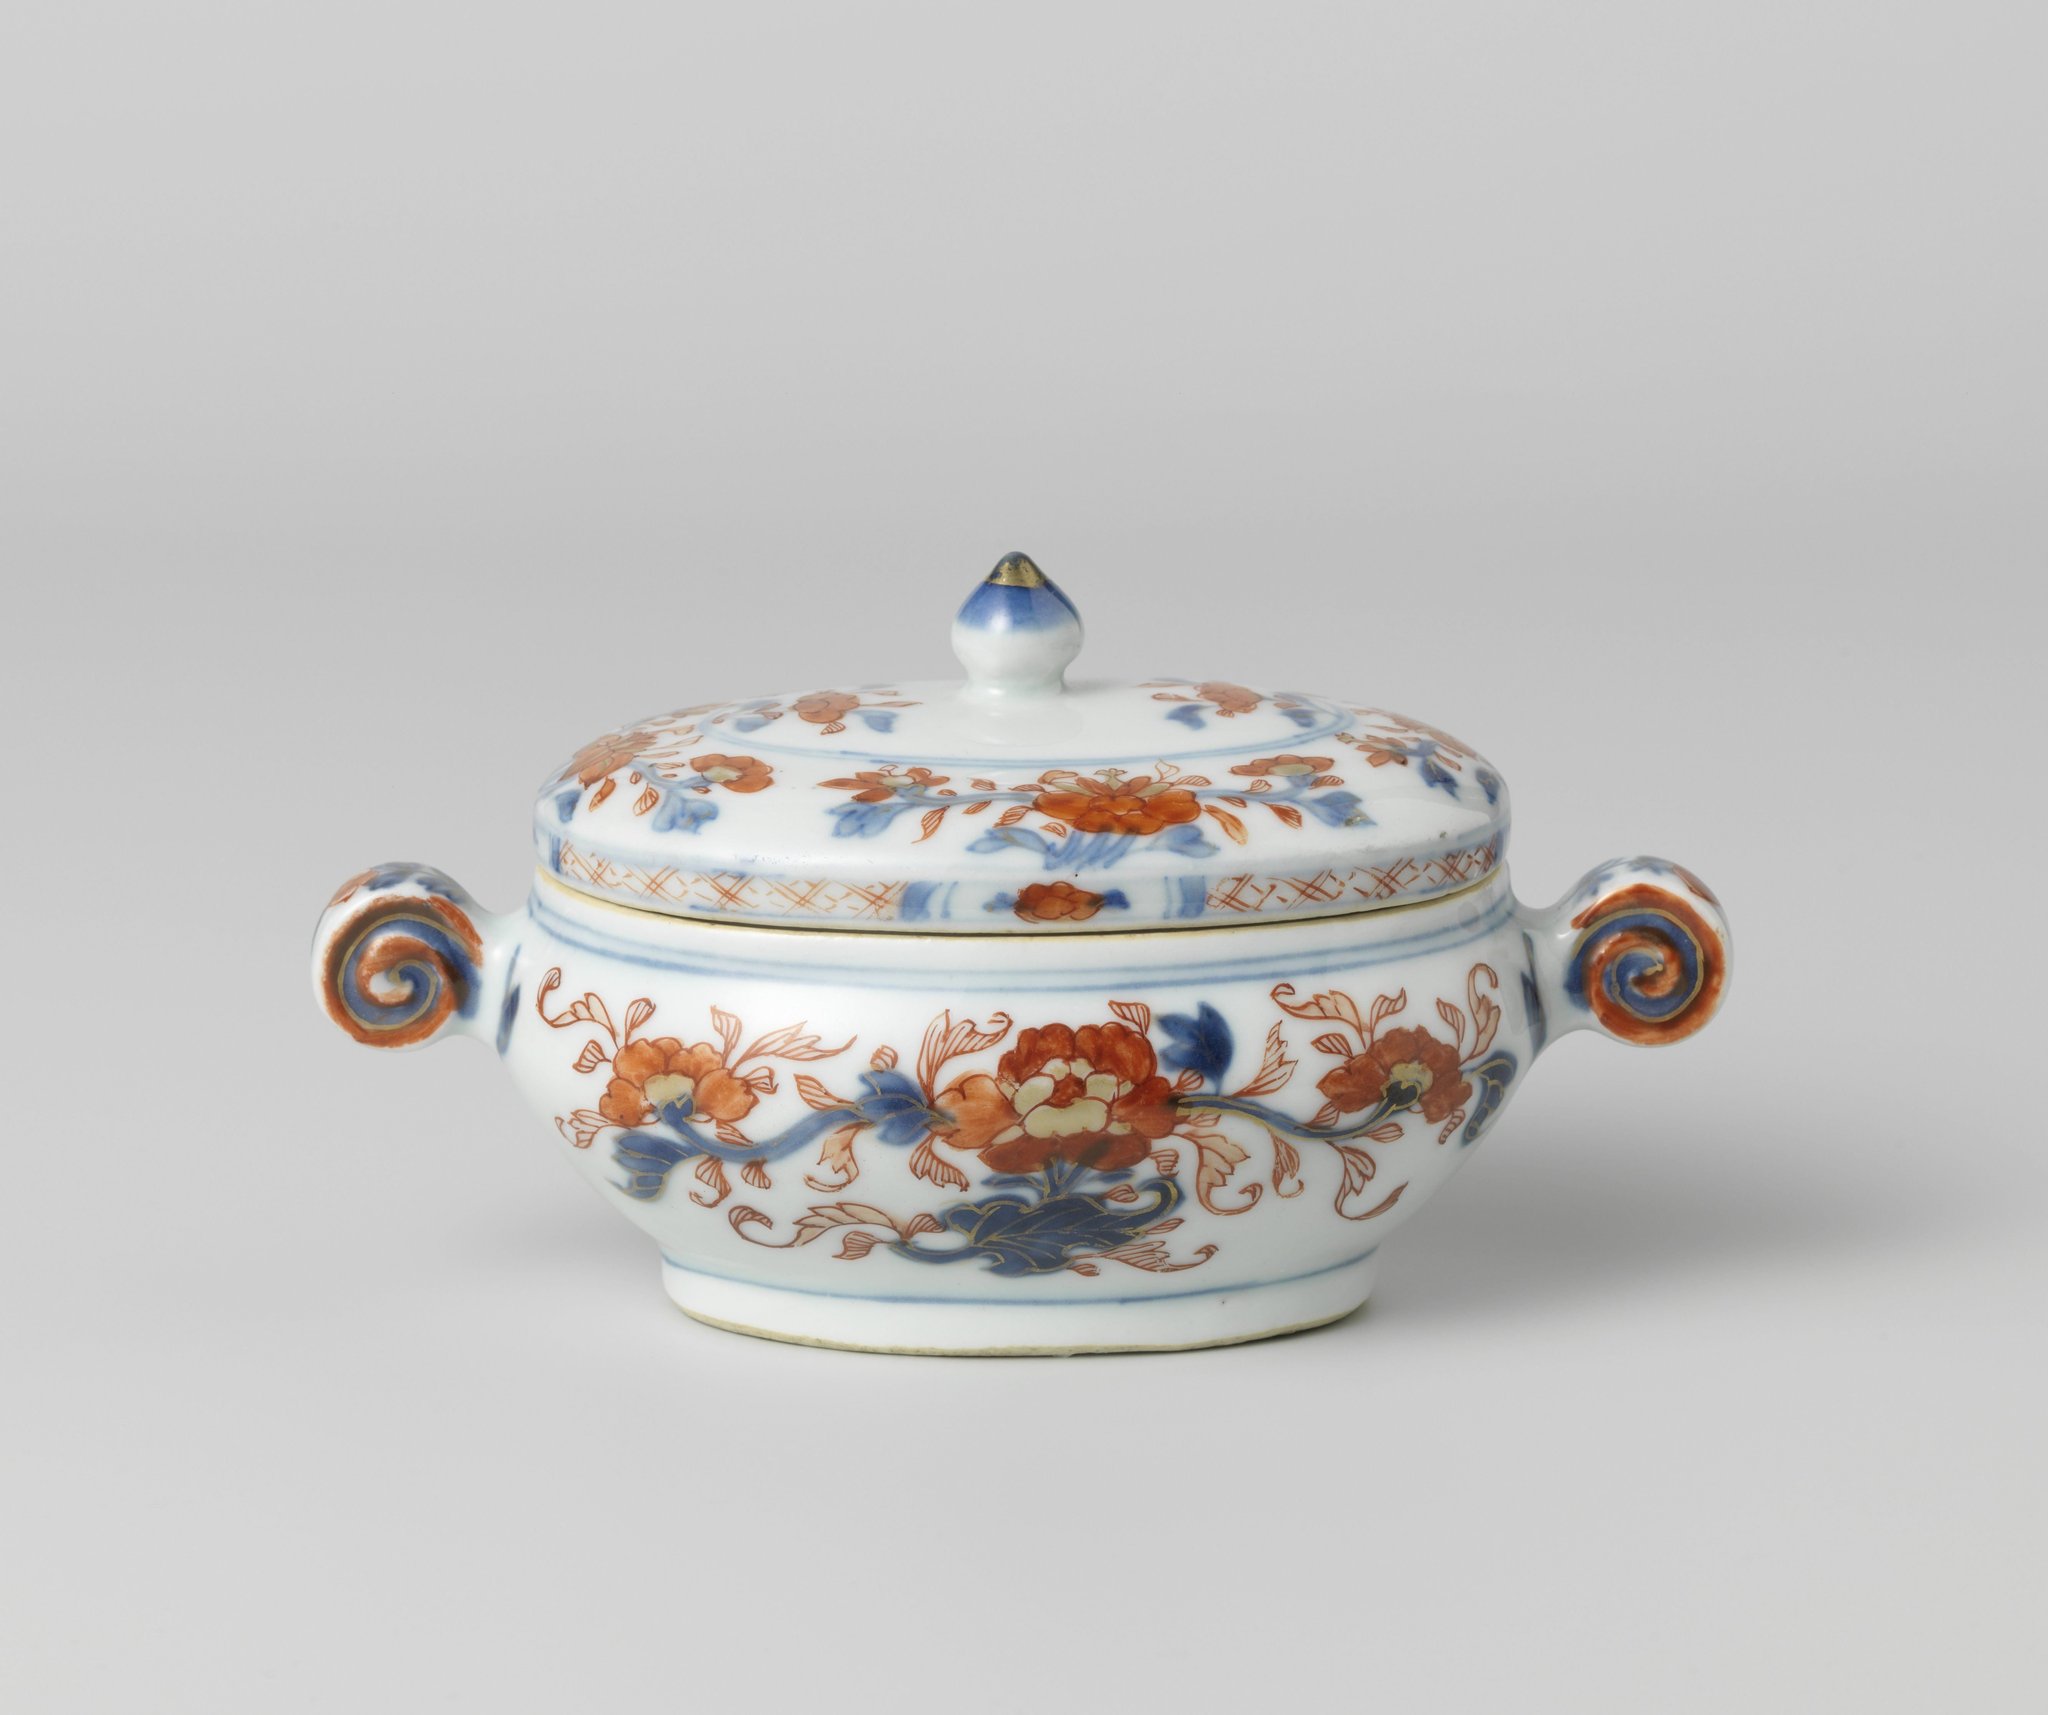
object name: tureen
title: Tureen with flower sprays and two vertical scroll handles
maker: Anonymous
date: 1725-1849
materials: cobalt, glaze, gold, paint, porcelain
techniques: firing, forming, gilding, turning, vitrification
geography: china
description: Botervloot van poselein met deksel en oren, Imari. Beschilderd in blauw, oranje en goud.